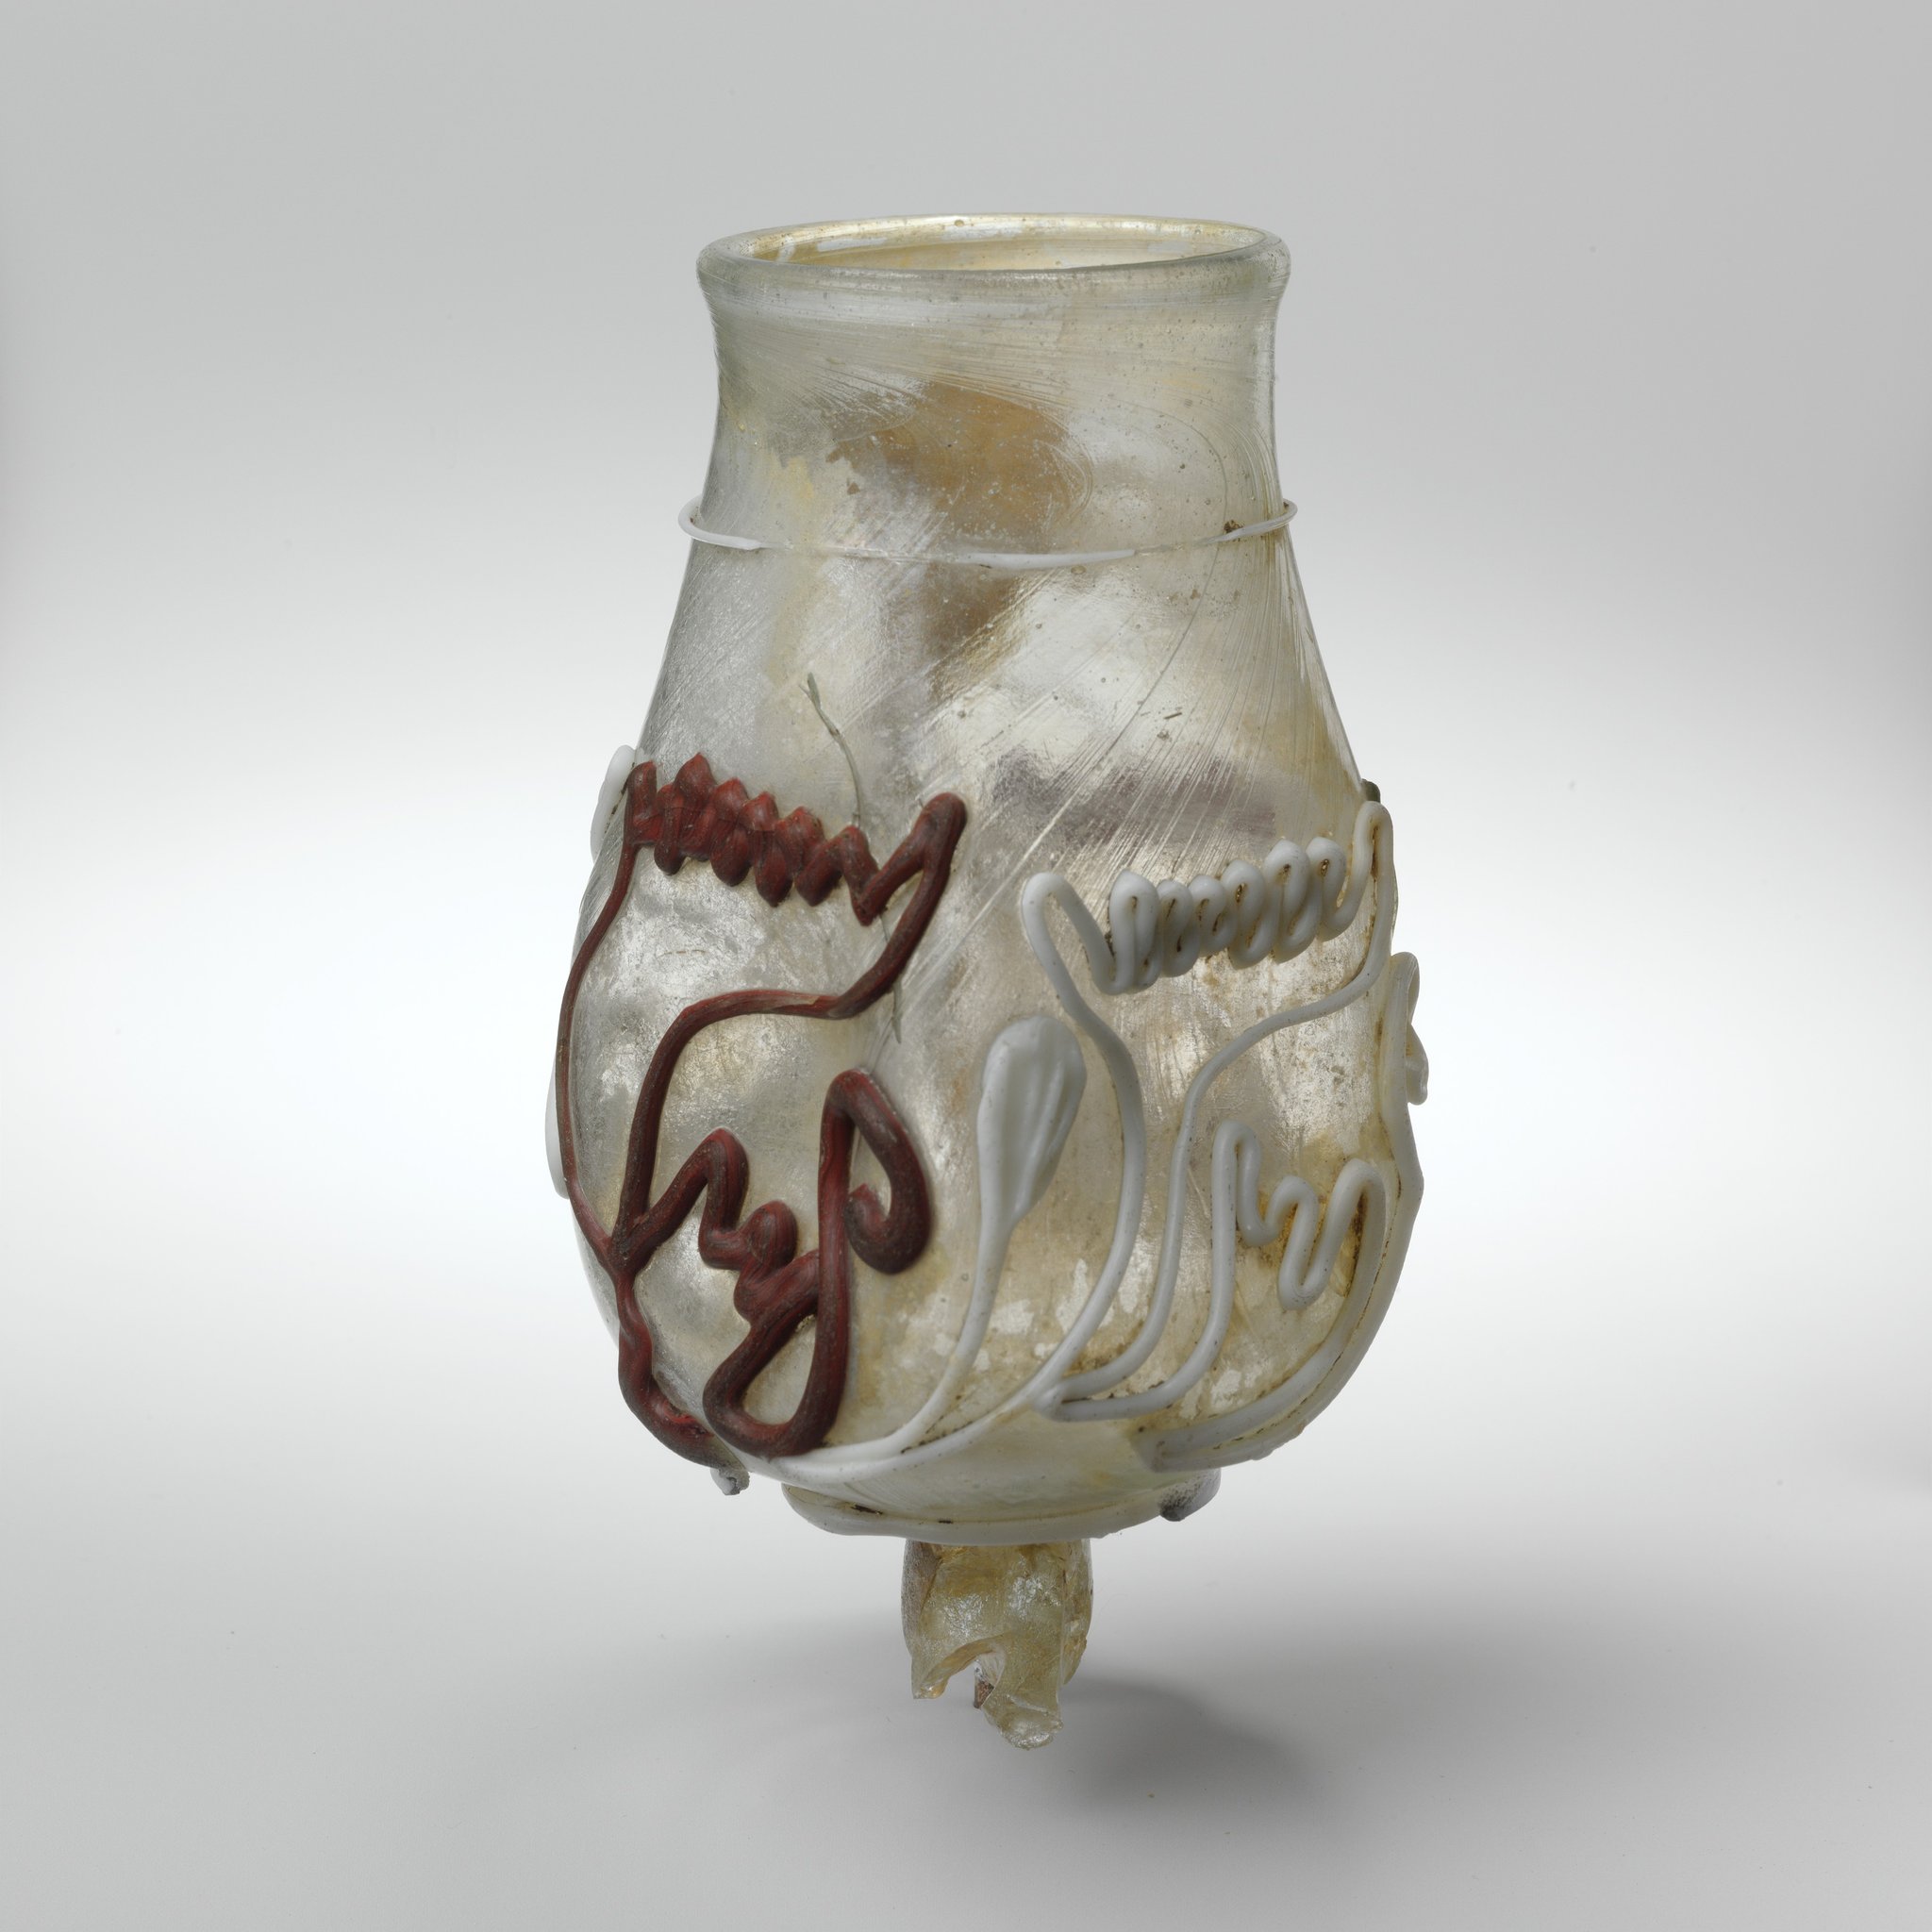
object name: goblet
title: Glass goblet with snake-thread decoration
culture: roman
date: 201-300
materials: glass